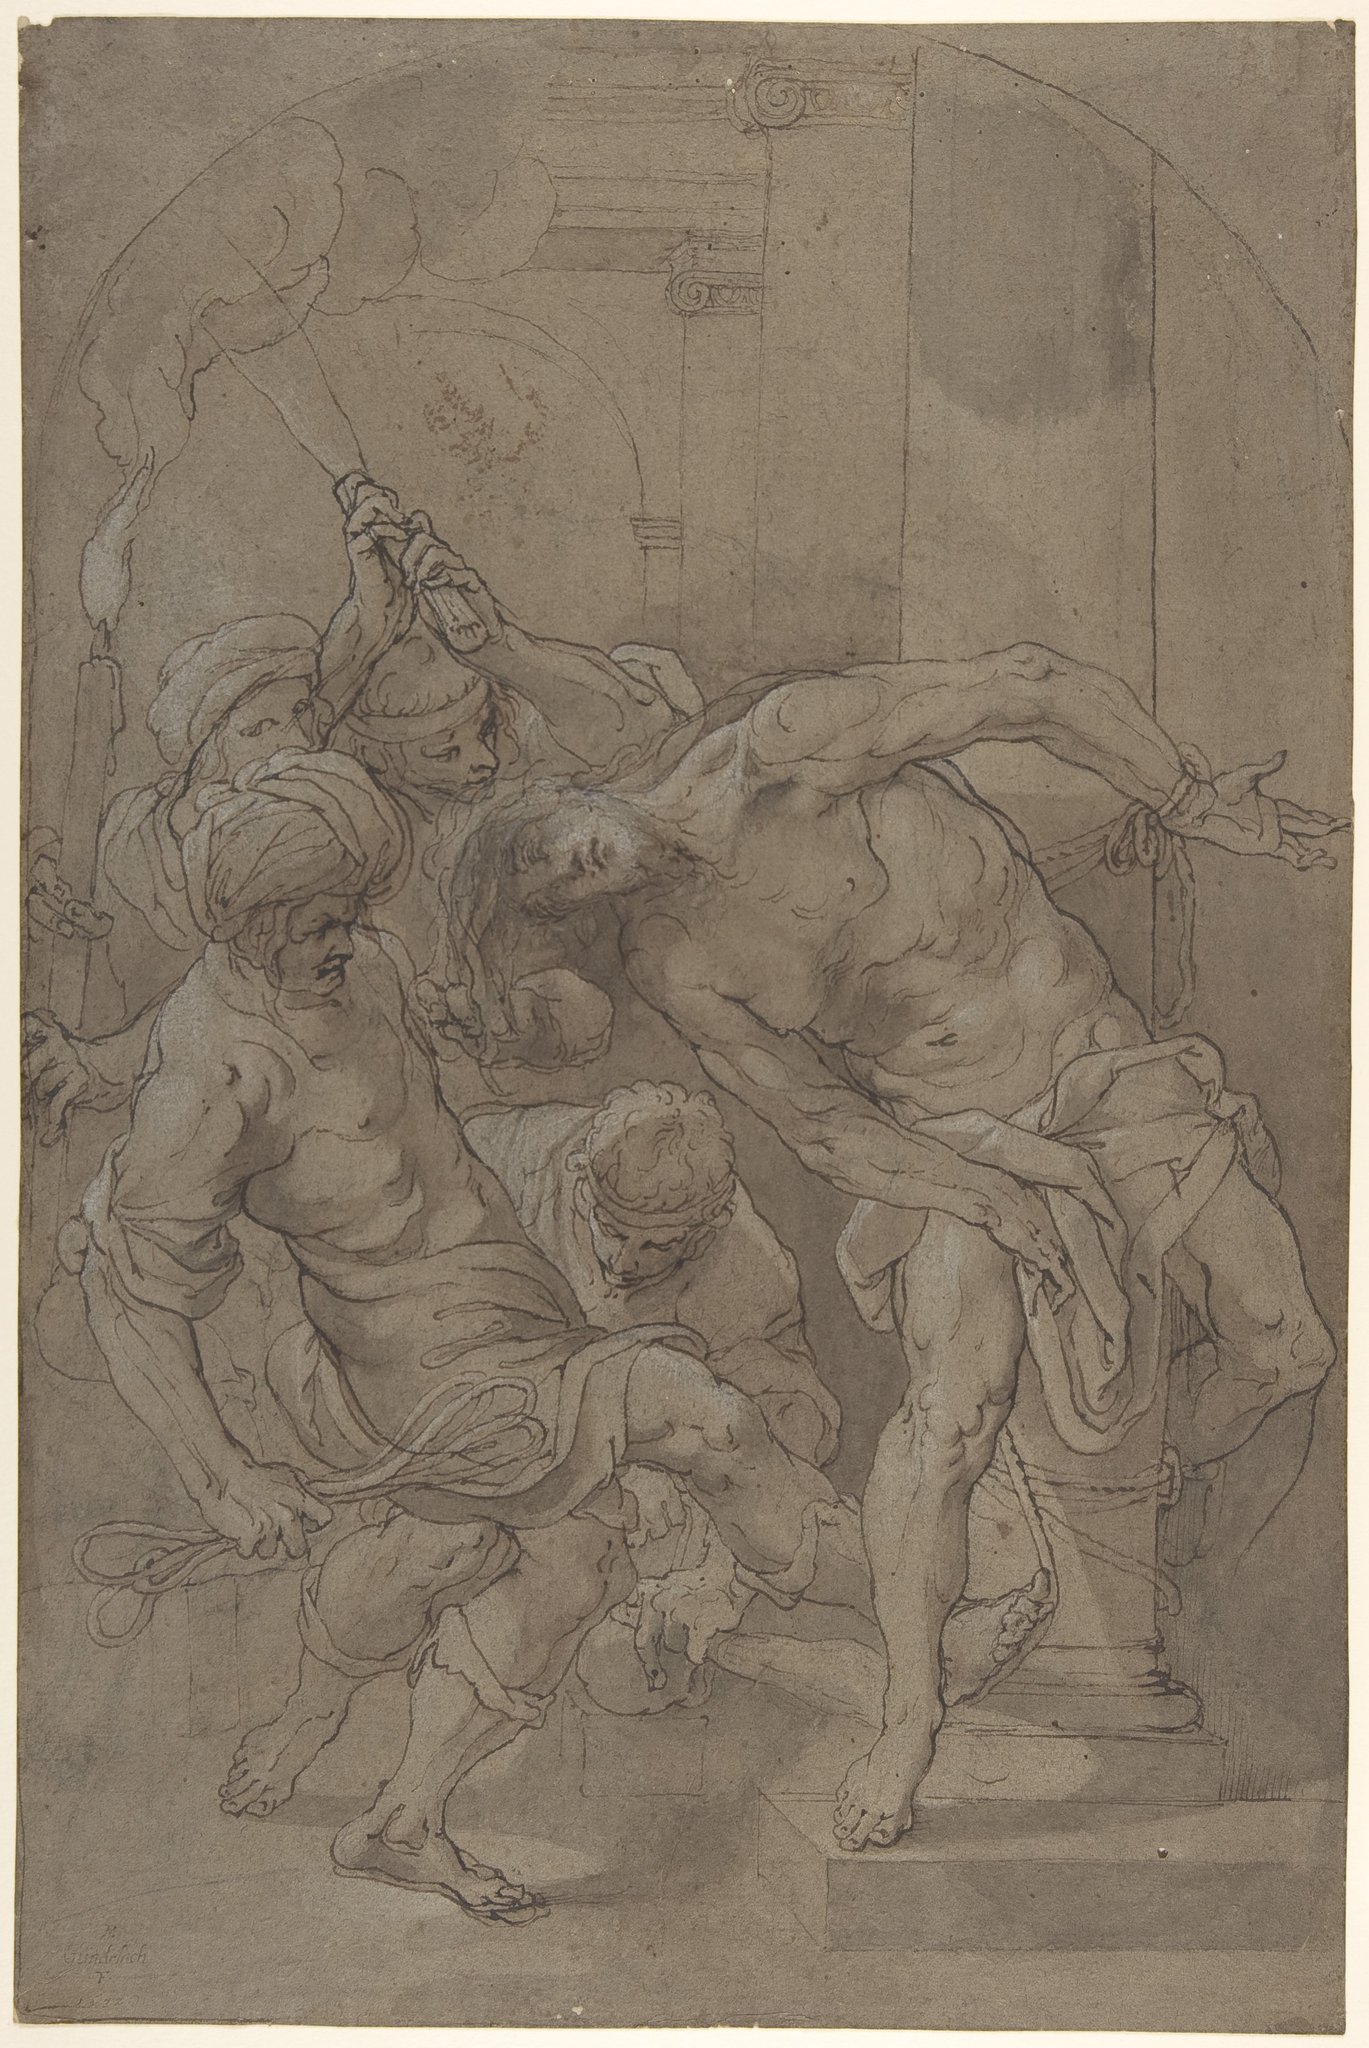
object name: drawing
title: The Flagellation of Christ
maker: matthäus gundelach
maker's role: artist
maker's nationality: german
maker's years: 1566-1653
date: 1632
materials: chalk, ink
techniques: brush, heightening, pen, wash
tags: men,christ